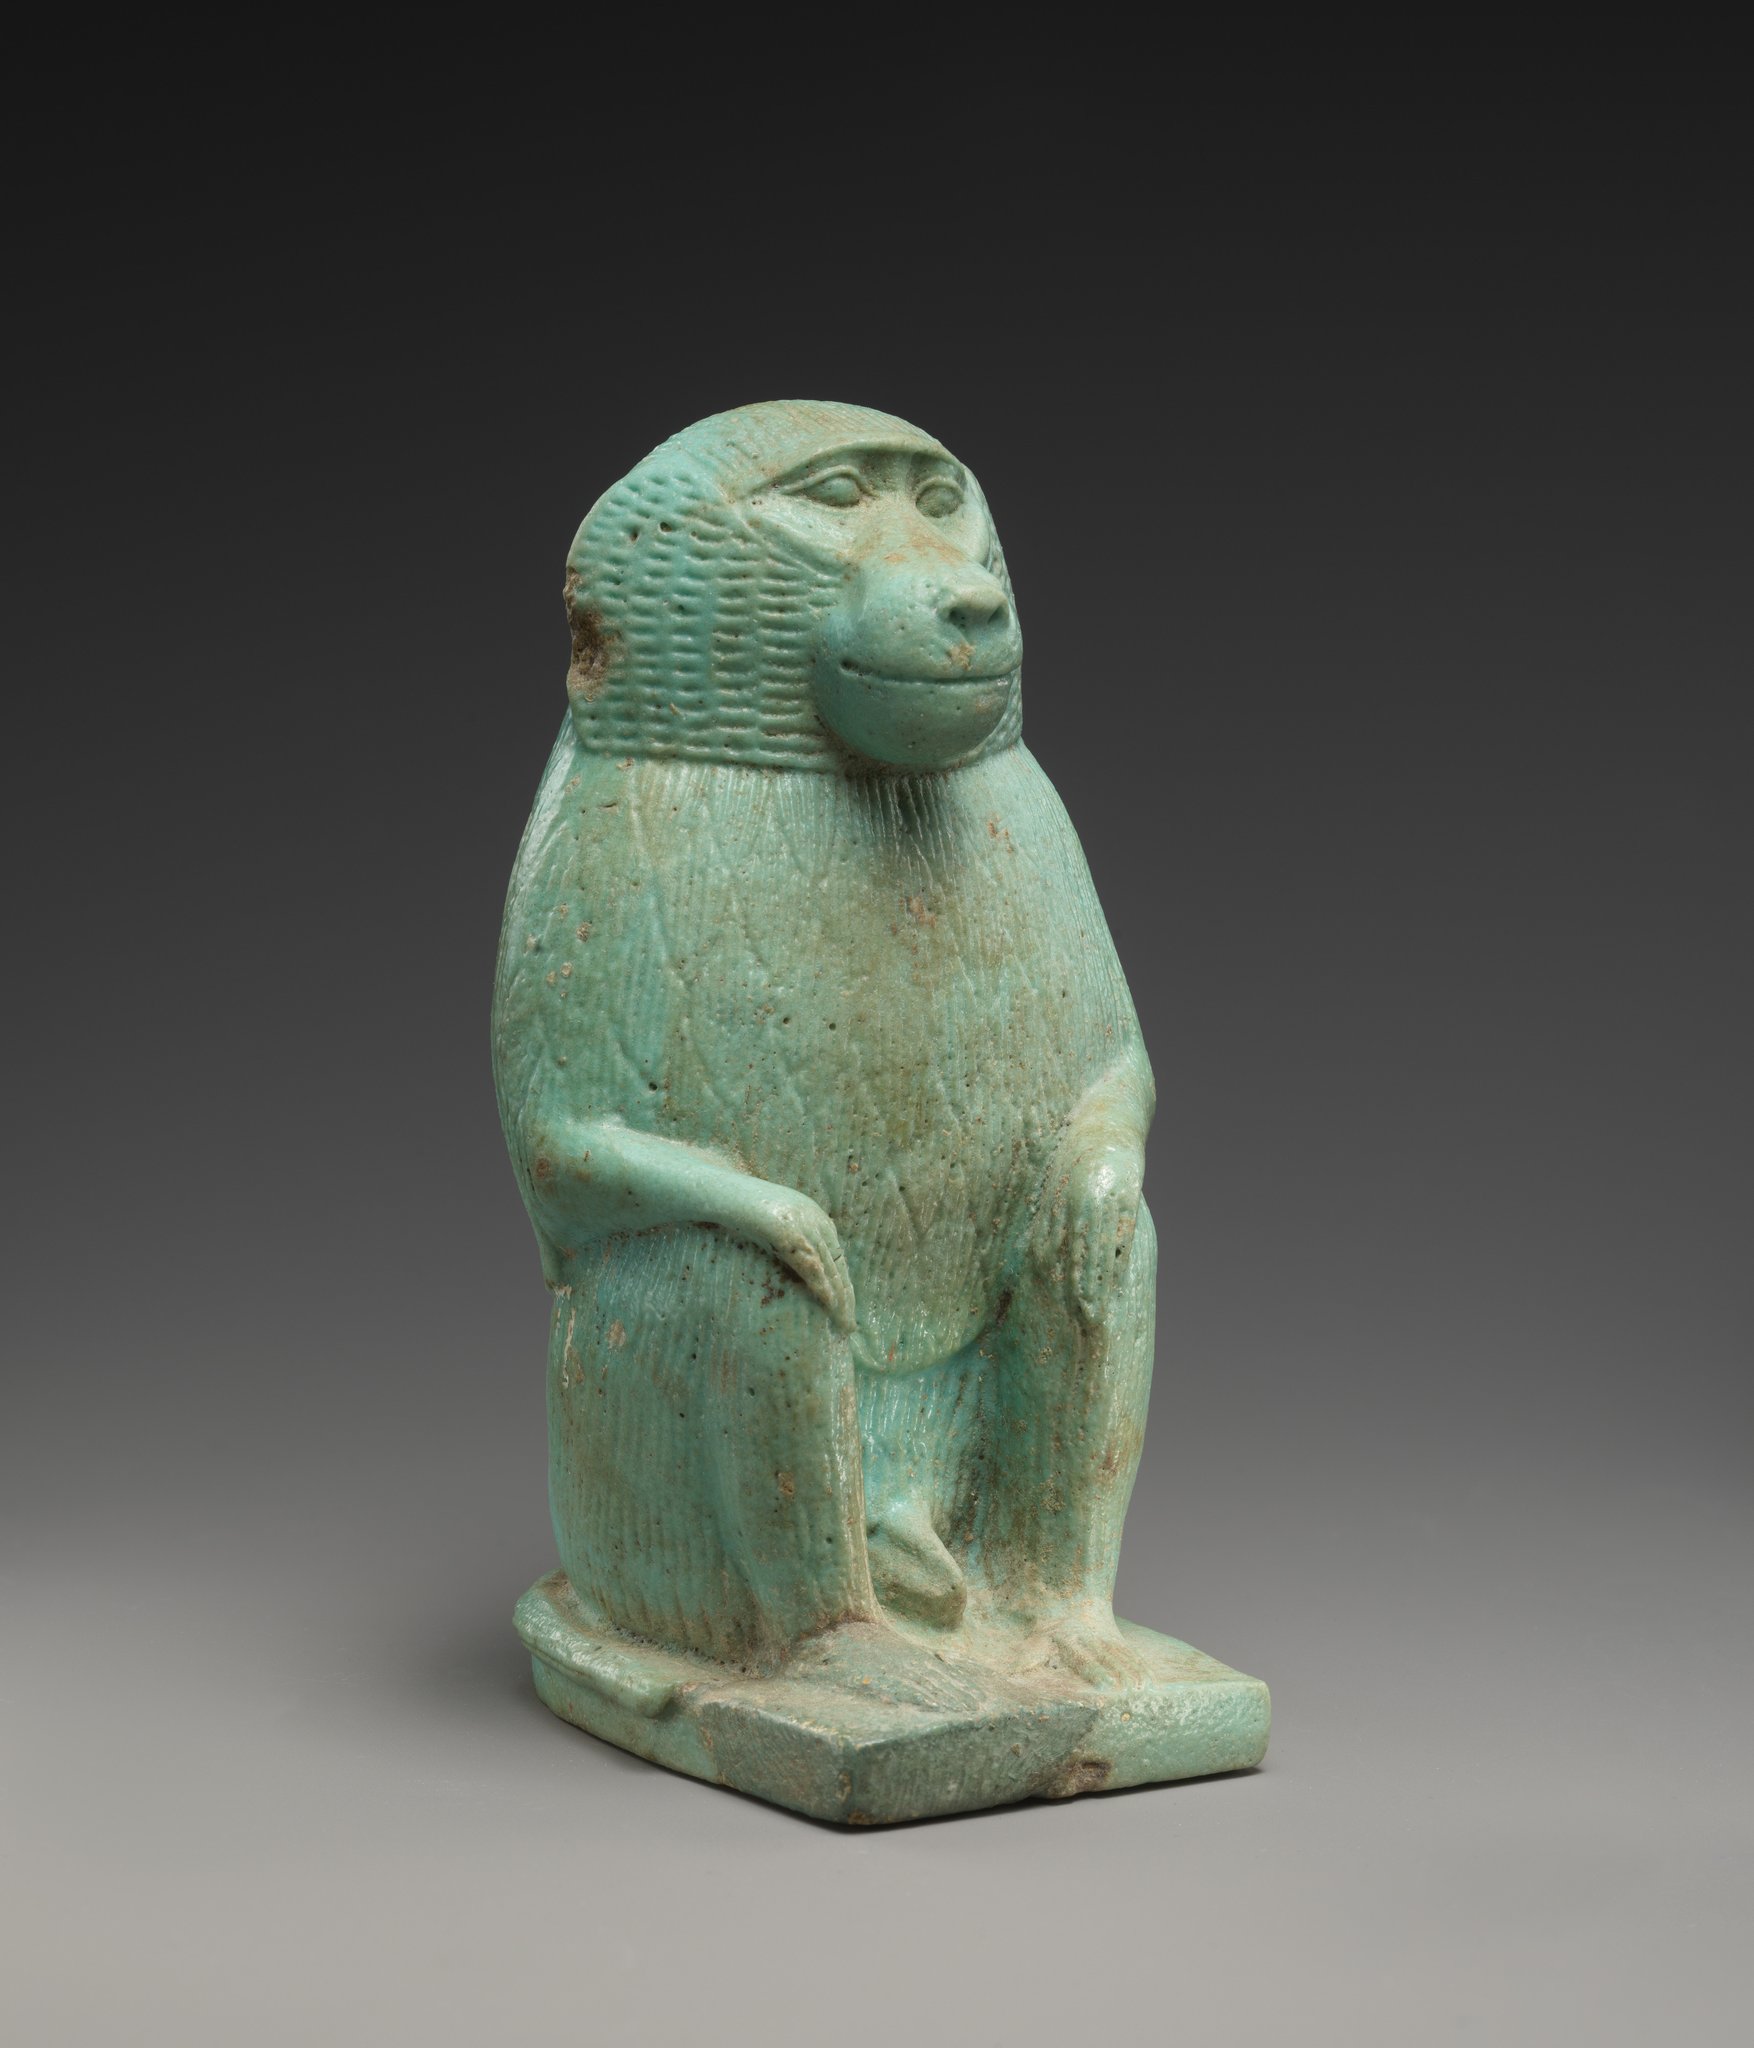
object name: amulet, baboon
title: Figure of a Baboon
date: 664-525 BCE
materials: faience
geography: memphite region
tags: baboons